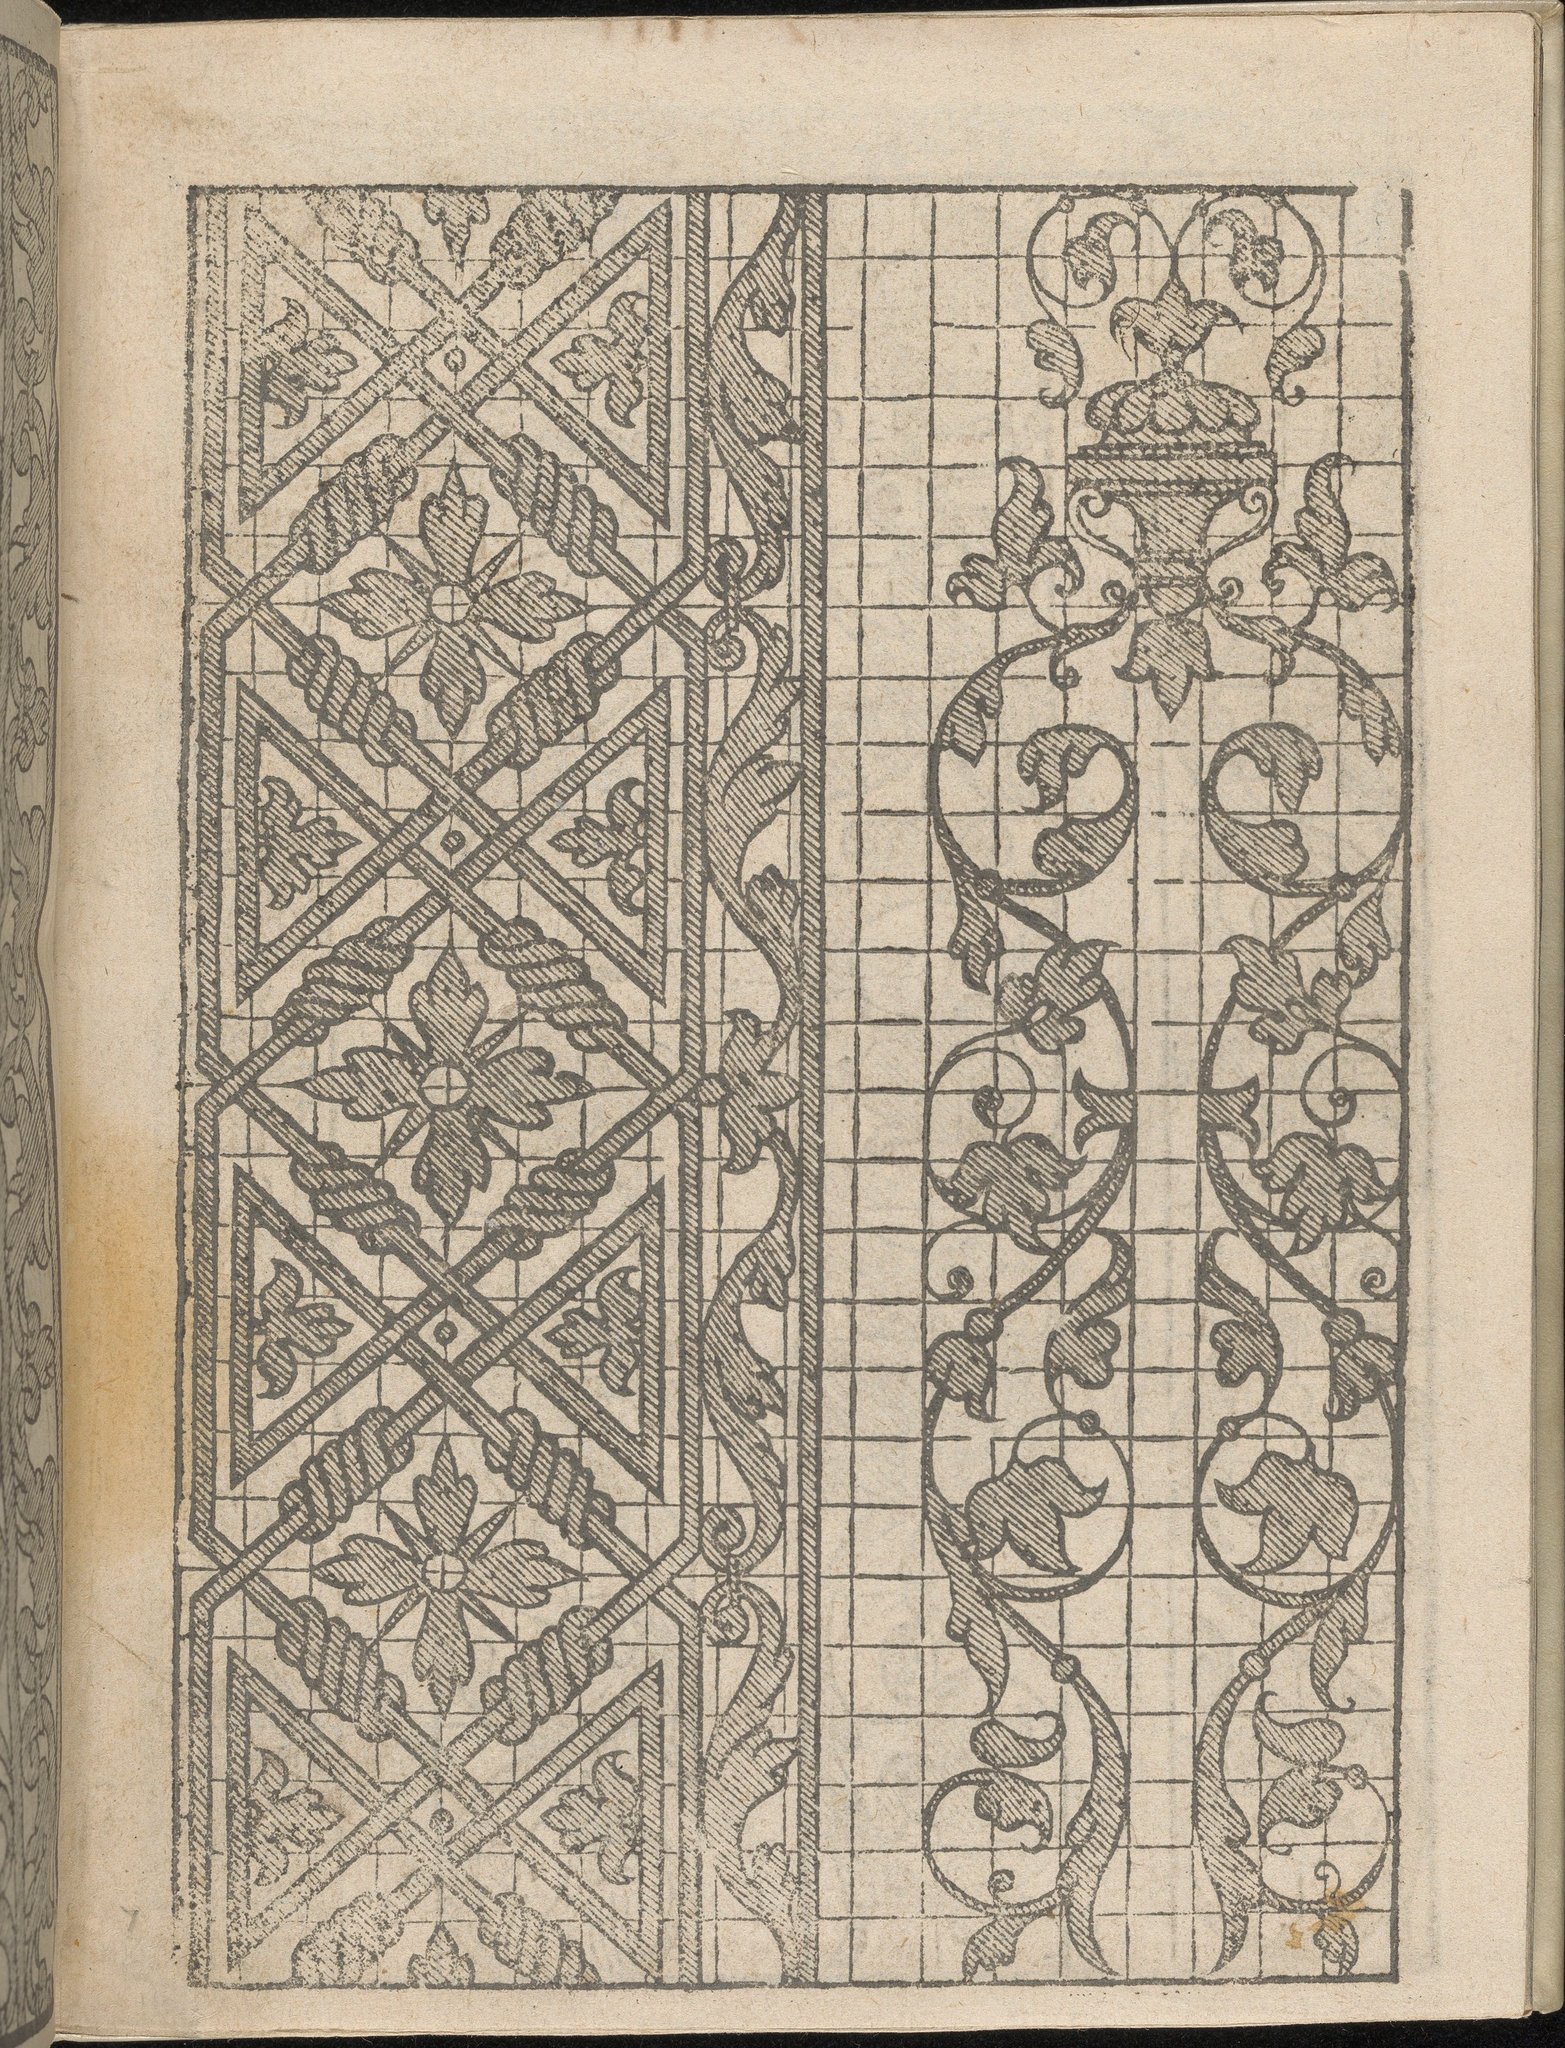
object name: book print ornament architecture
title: Lucidario di Recami, page 7 (verso)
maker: iseppo foresto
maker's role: designer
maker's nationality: italian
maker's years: 1520-1580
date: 1564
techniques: woodcut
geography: italy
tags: flowers,acorns